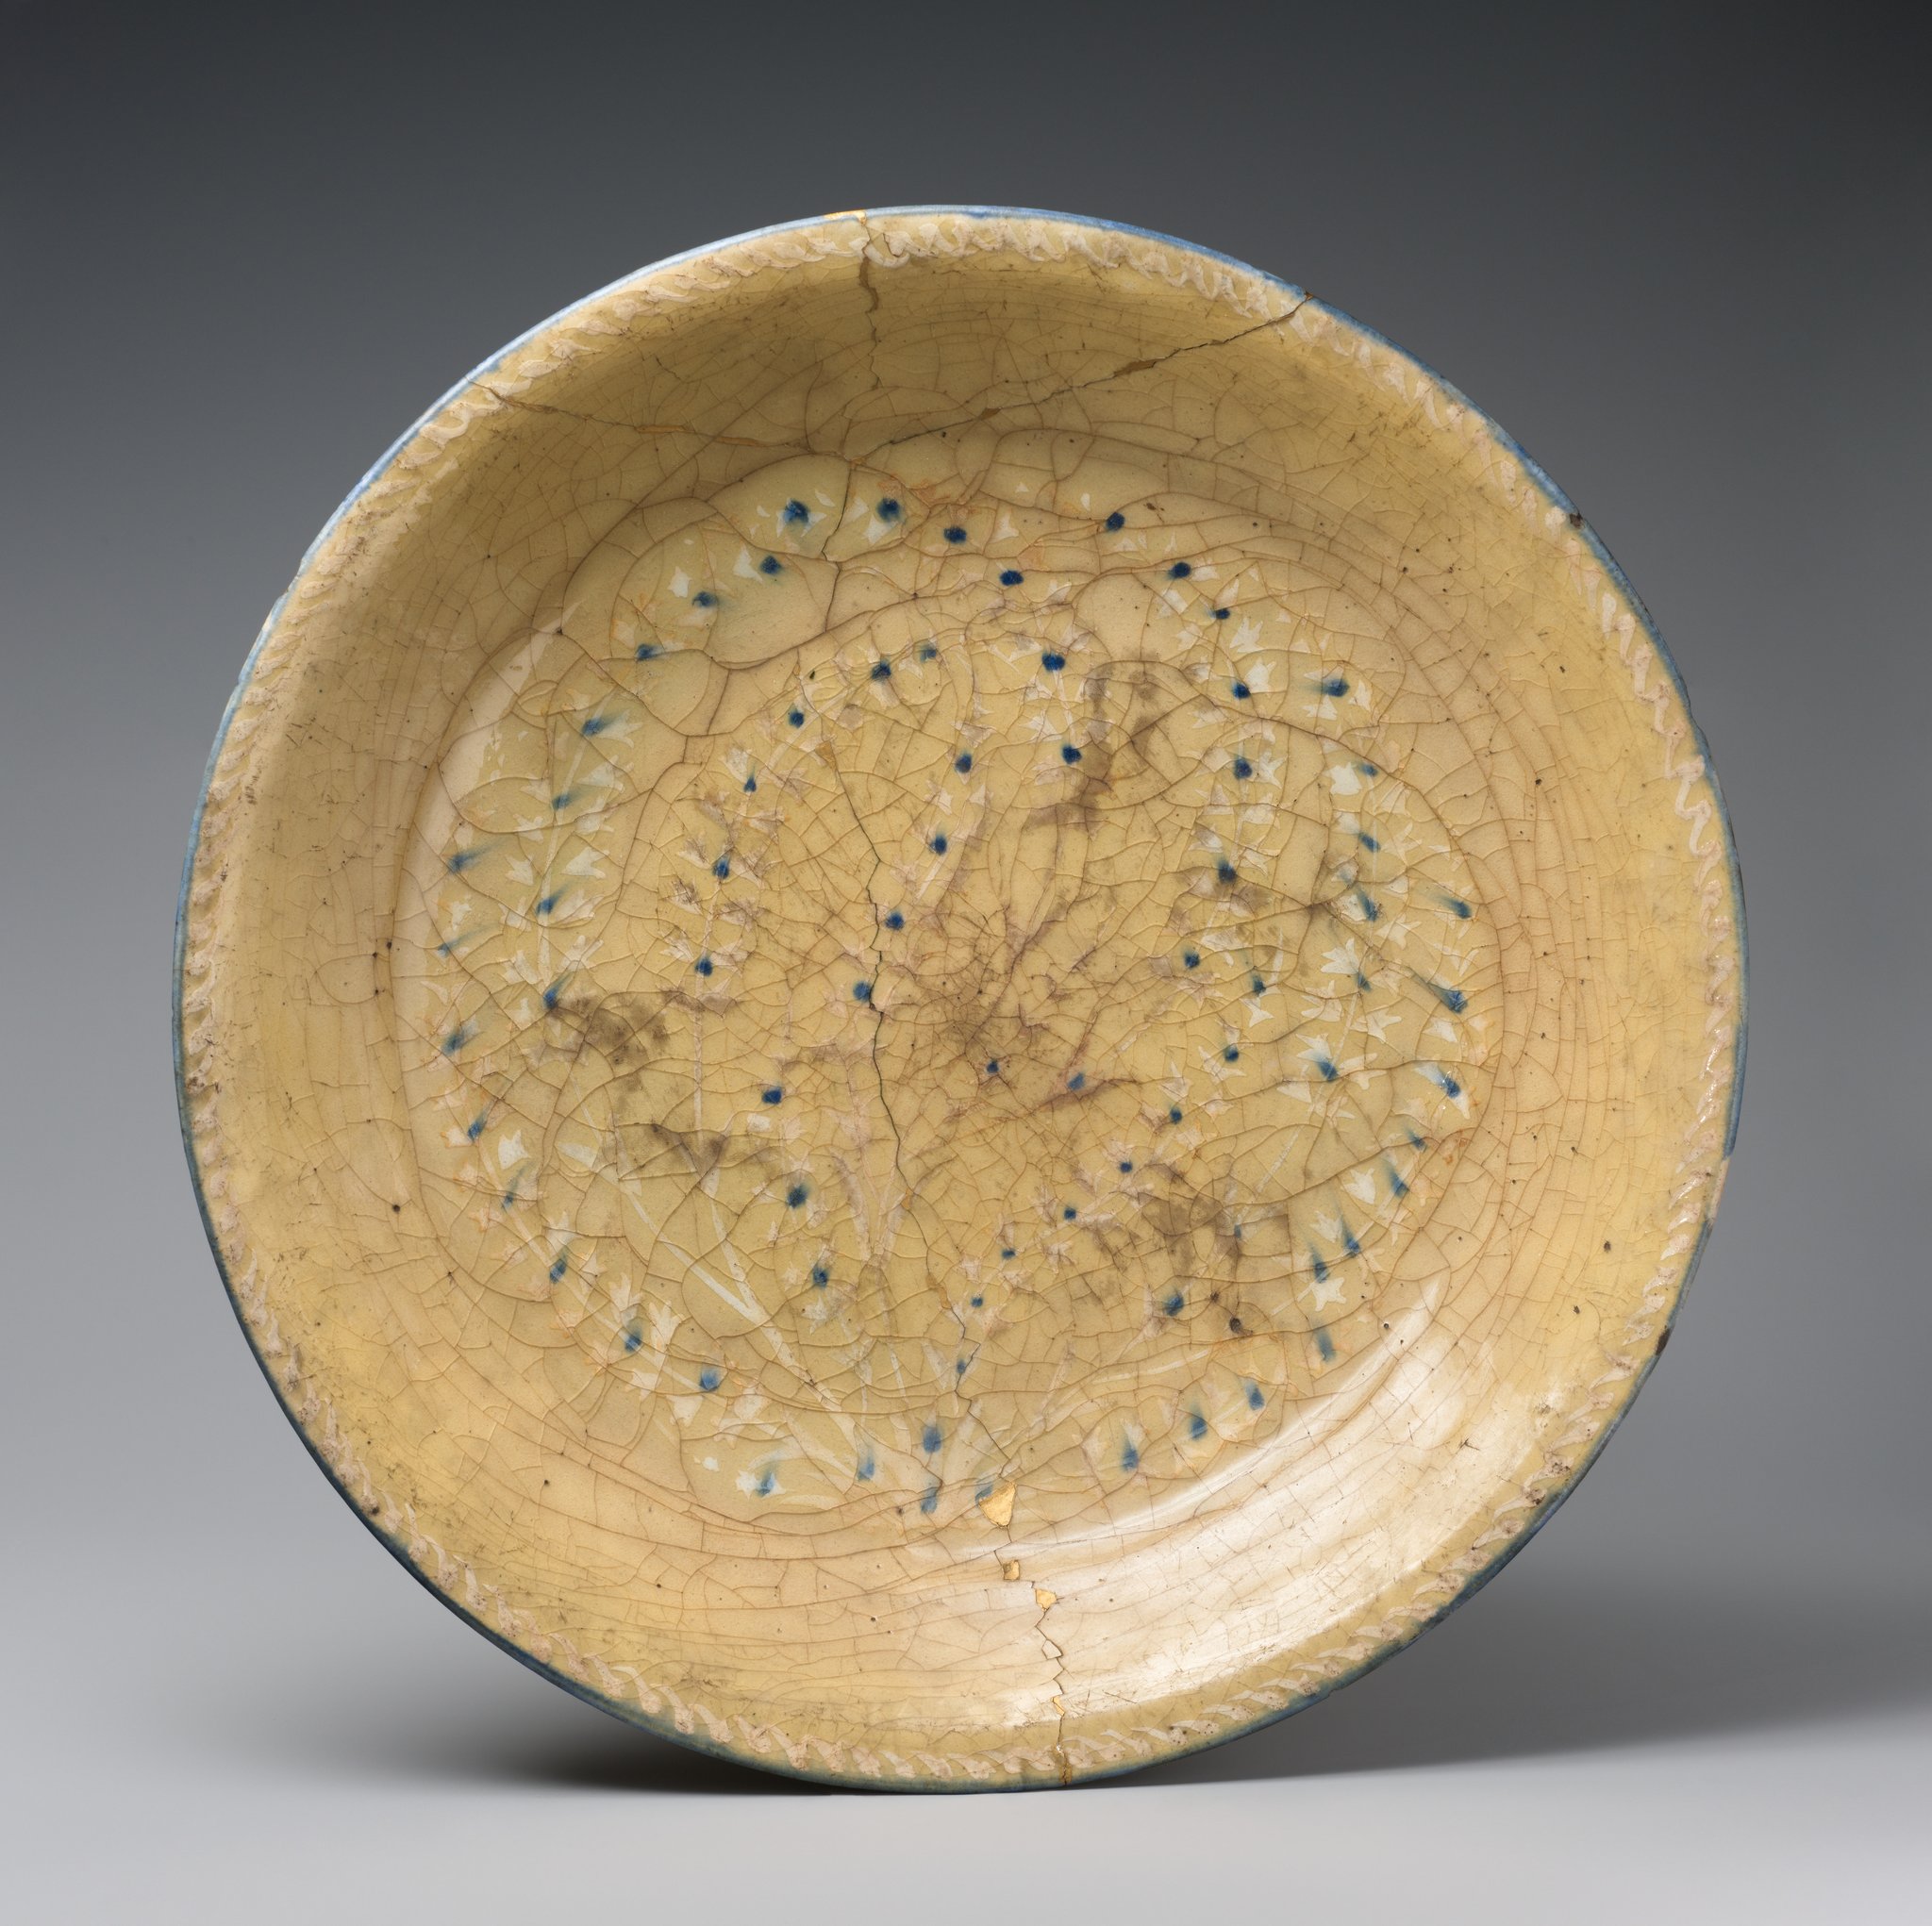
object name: dish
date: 1701-1800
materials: stonepaste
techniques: glazing, painting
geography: kerman